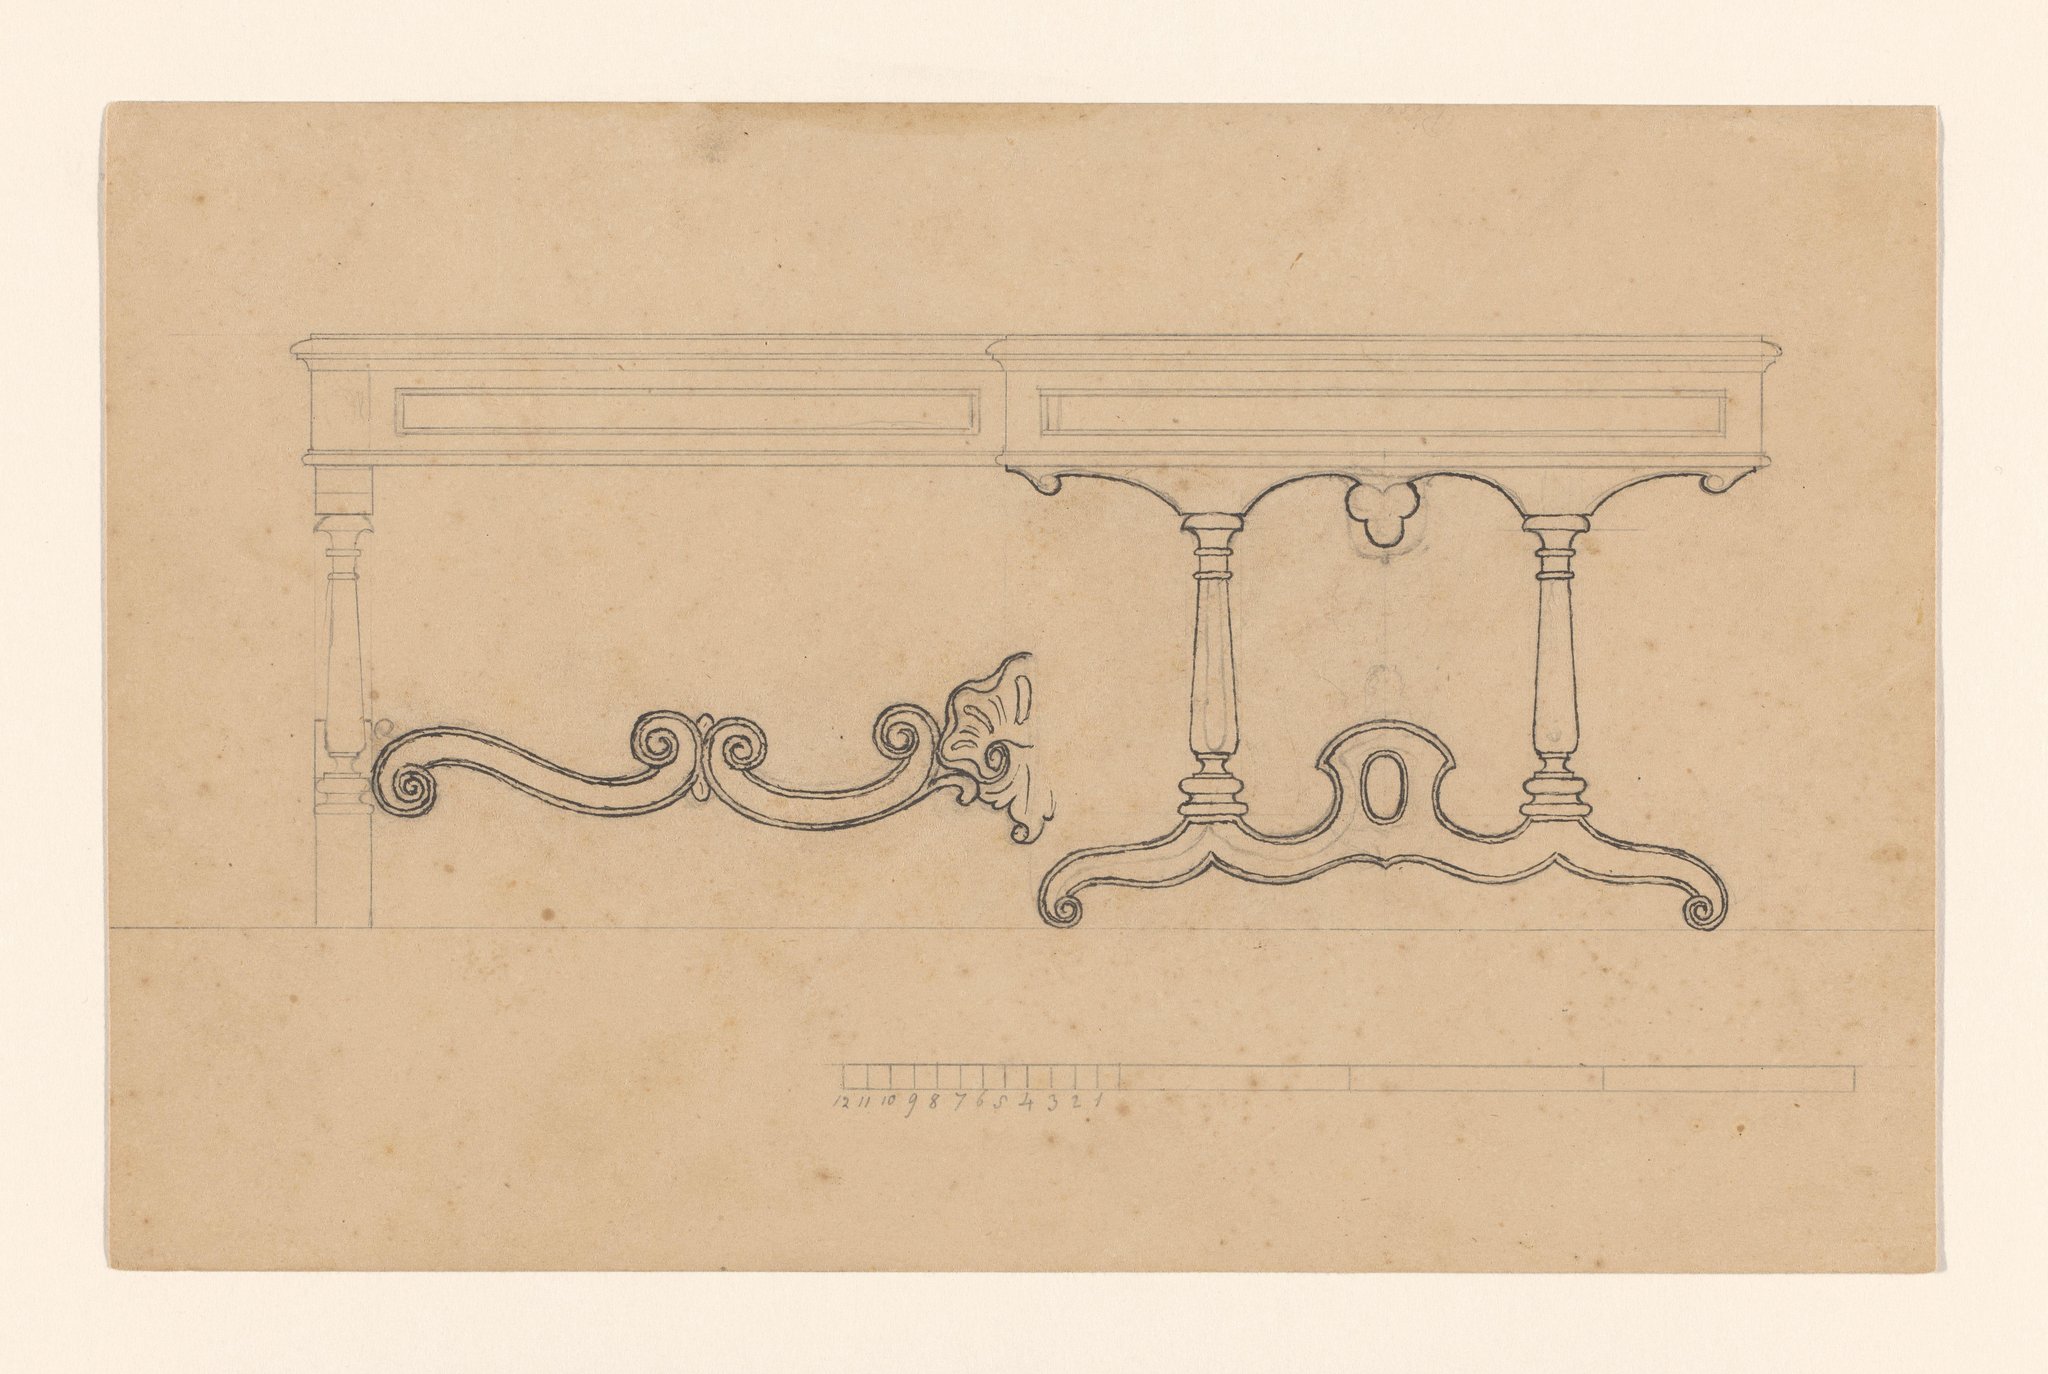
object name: drawing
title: Ontwerp voor een tafel, met een gecombineerd voor- en zijaanzicht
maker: joseph kusterer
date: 1865-1870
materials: graphite, ink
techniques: drawing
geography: mainz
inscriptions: size: ‘Maatverdeling met 12 11 10 9 8 7 6 5 4 3 2 1’